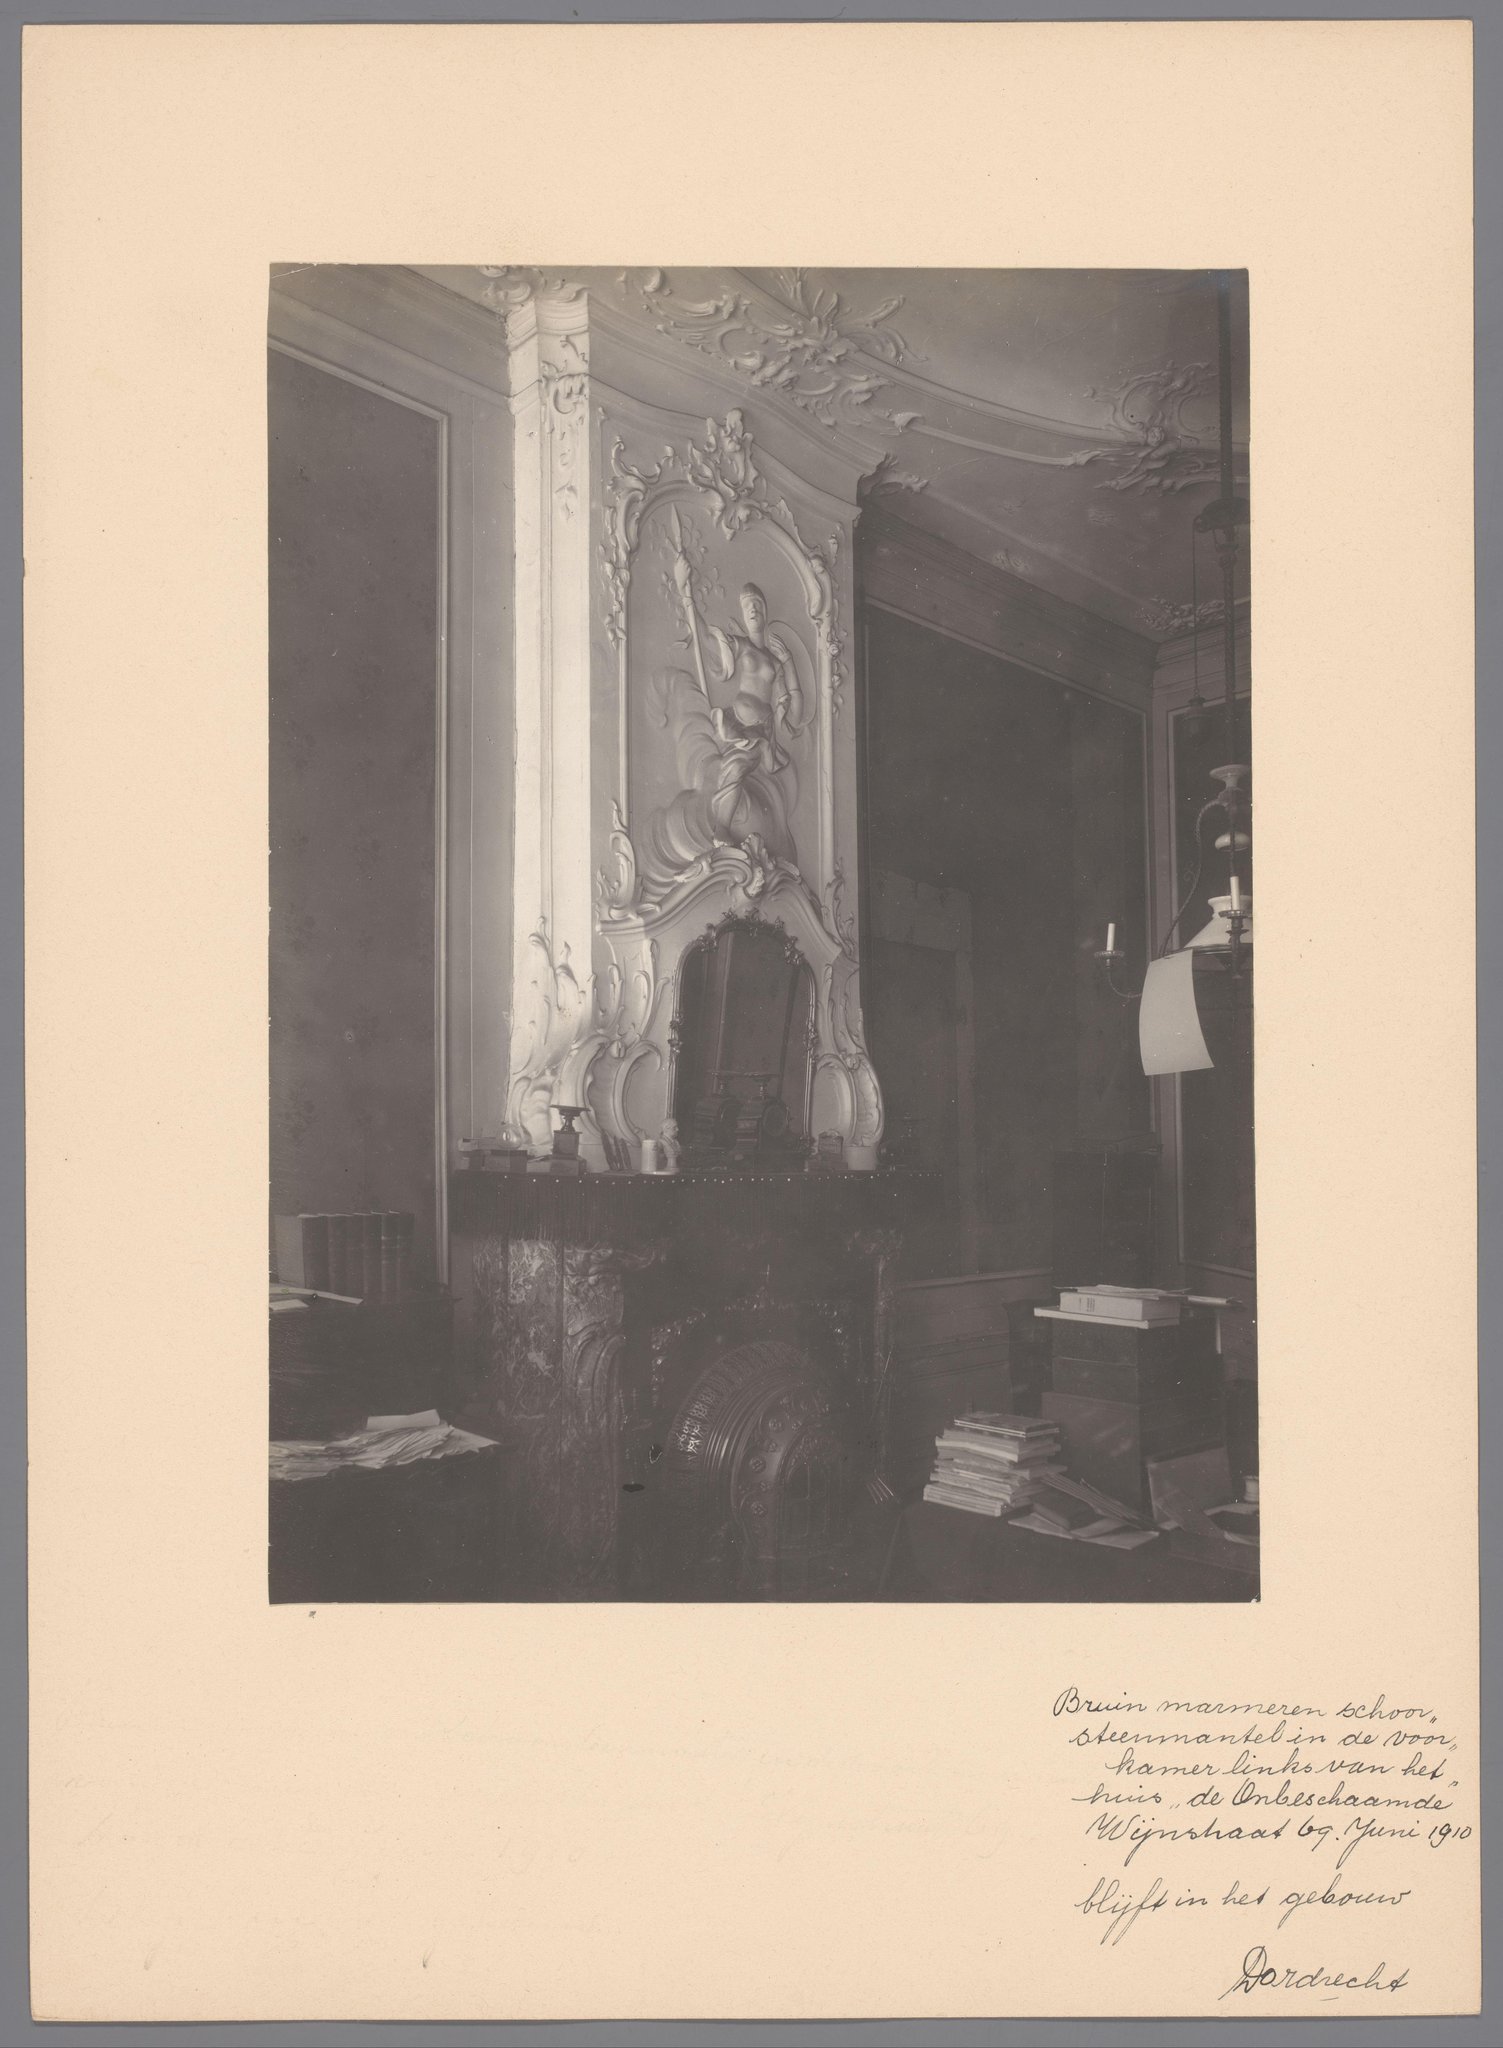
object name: photograph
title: Interieur met een marmeren schoorsteenmantel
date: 1910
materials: cardboard, photographic support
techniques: gelatin silver print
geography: wijnstraat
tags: open hearth, fire-place, interior of the house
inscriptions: annotation: ‘Bruin marmeren schoorsteenmantel in de voorkamer links van het huis "de onbeschaamde" Wijnstraat 69/ Juni 1910/ blijft in het gebouw/ Dordrecht’